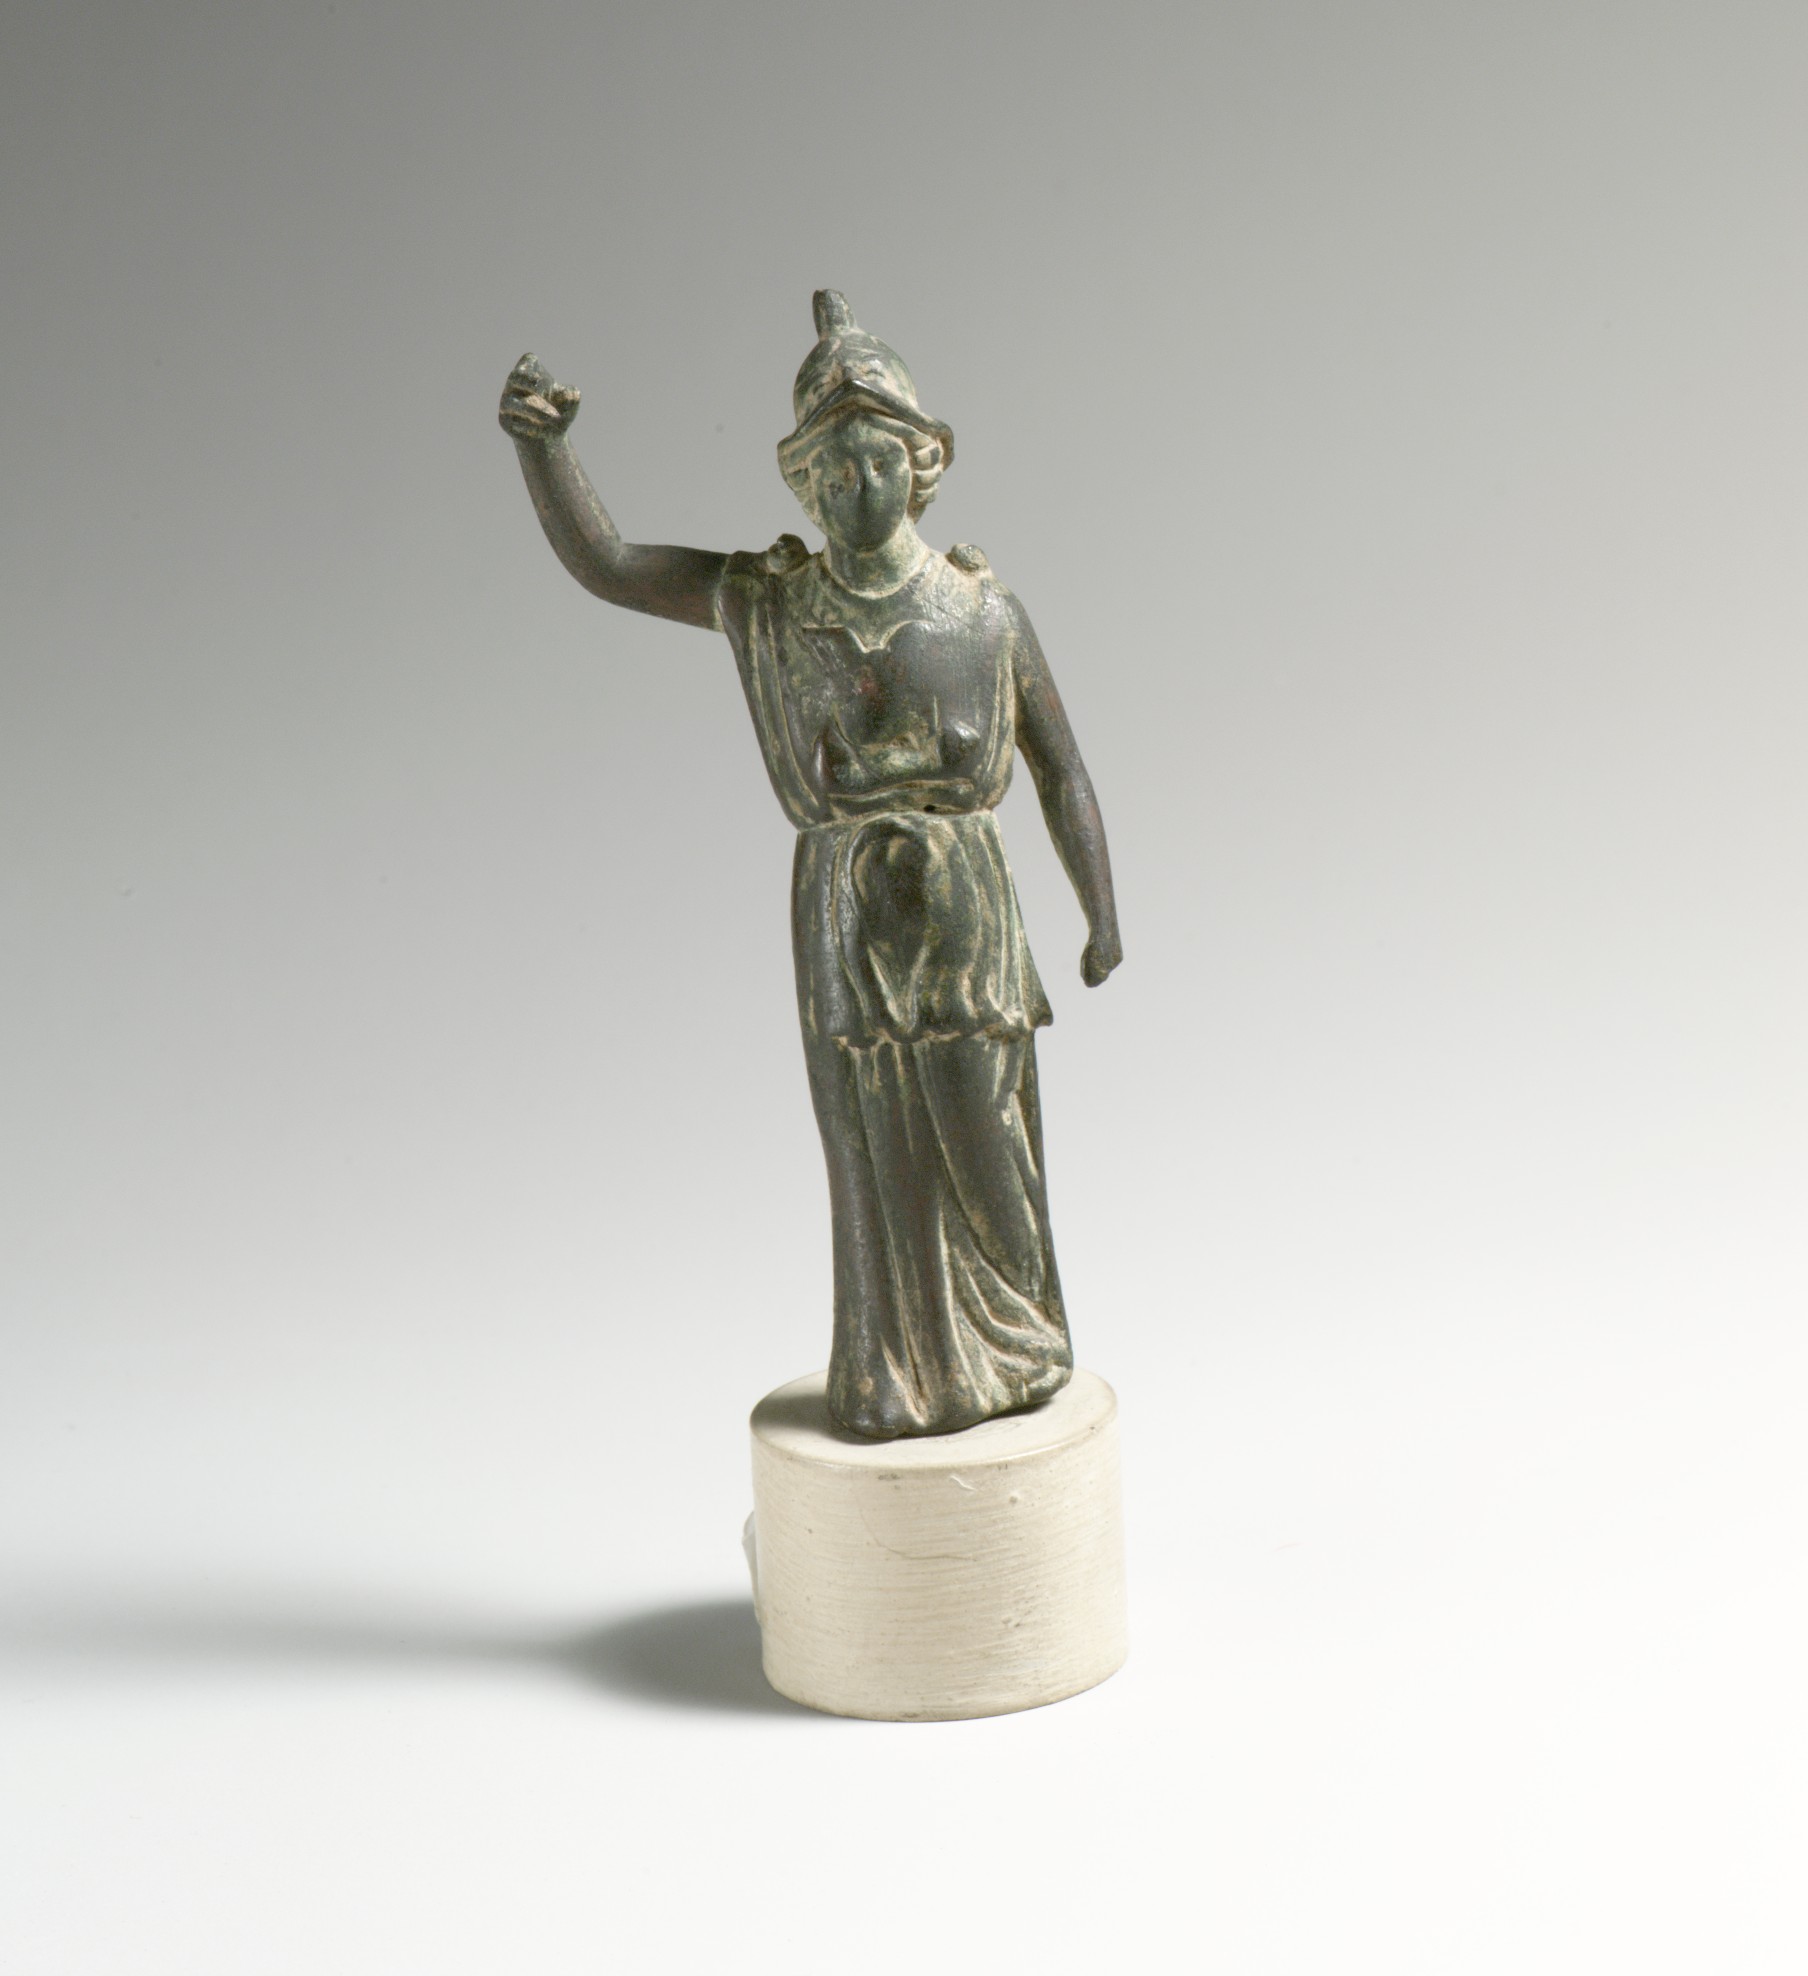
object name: statuette of athena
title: Bronze statuette of Athena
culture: roman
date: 101-300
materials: bronze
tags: athena